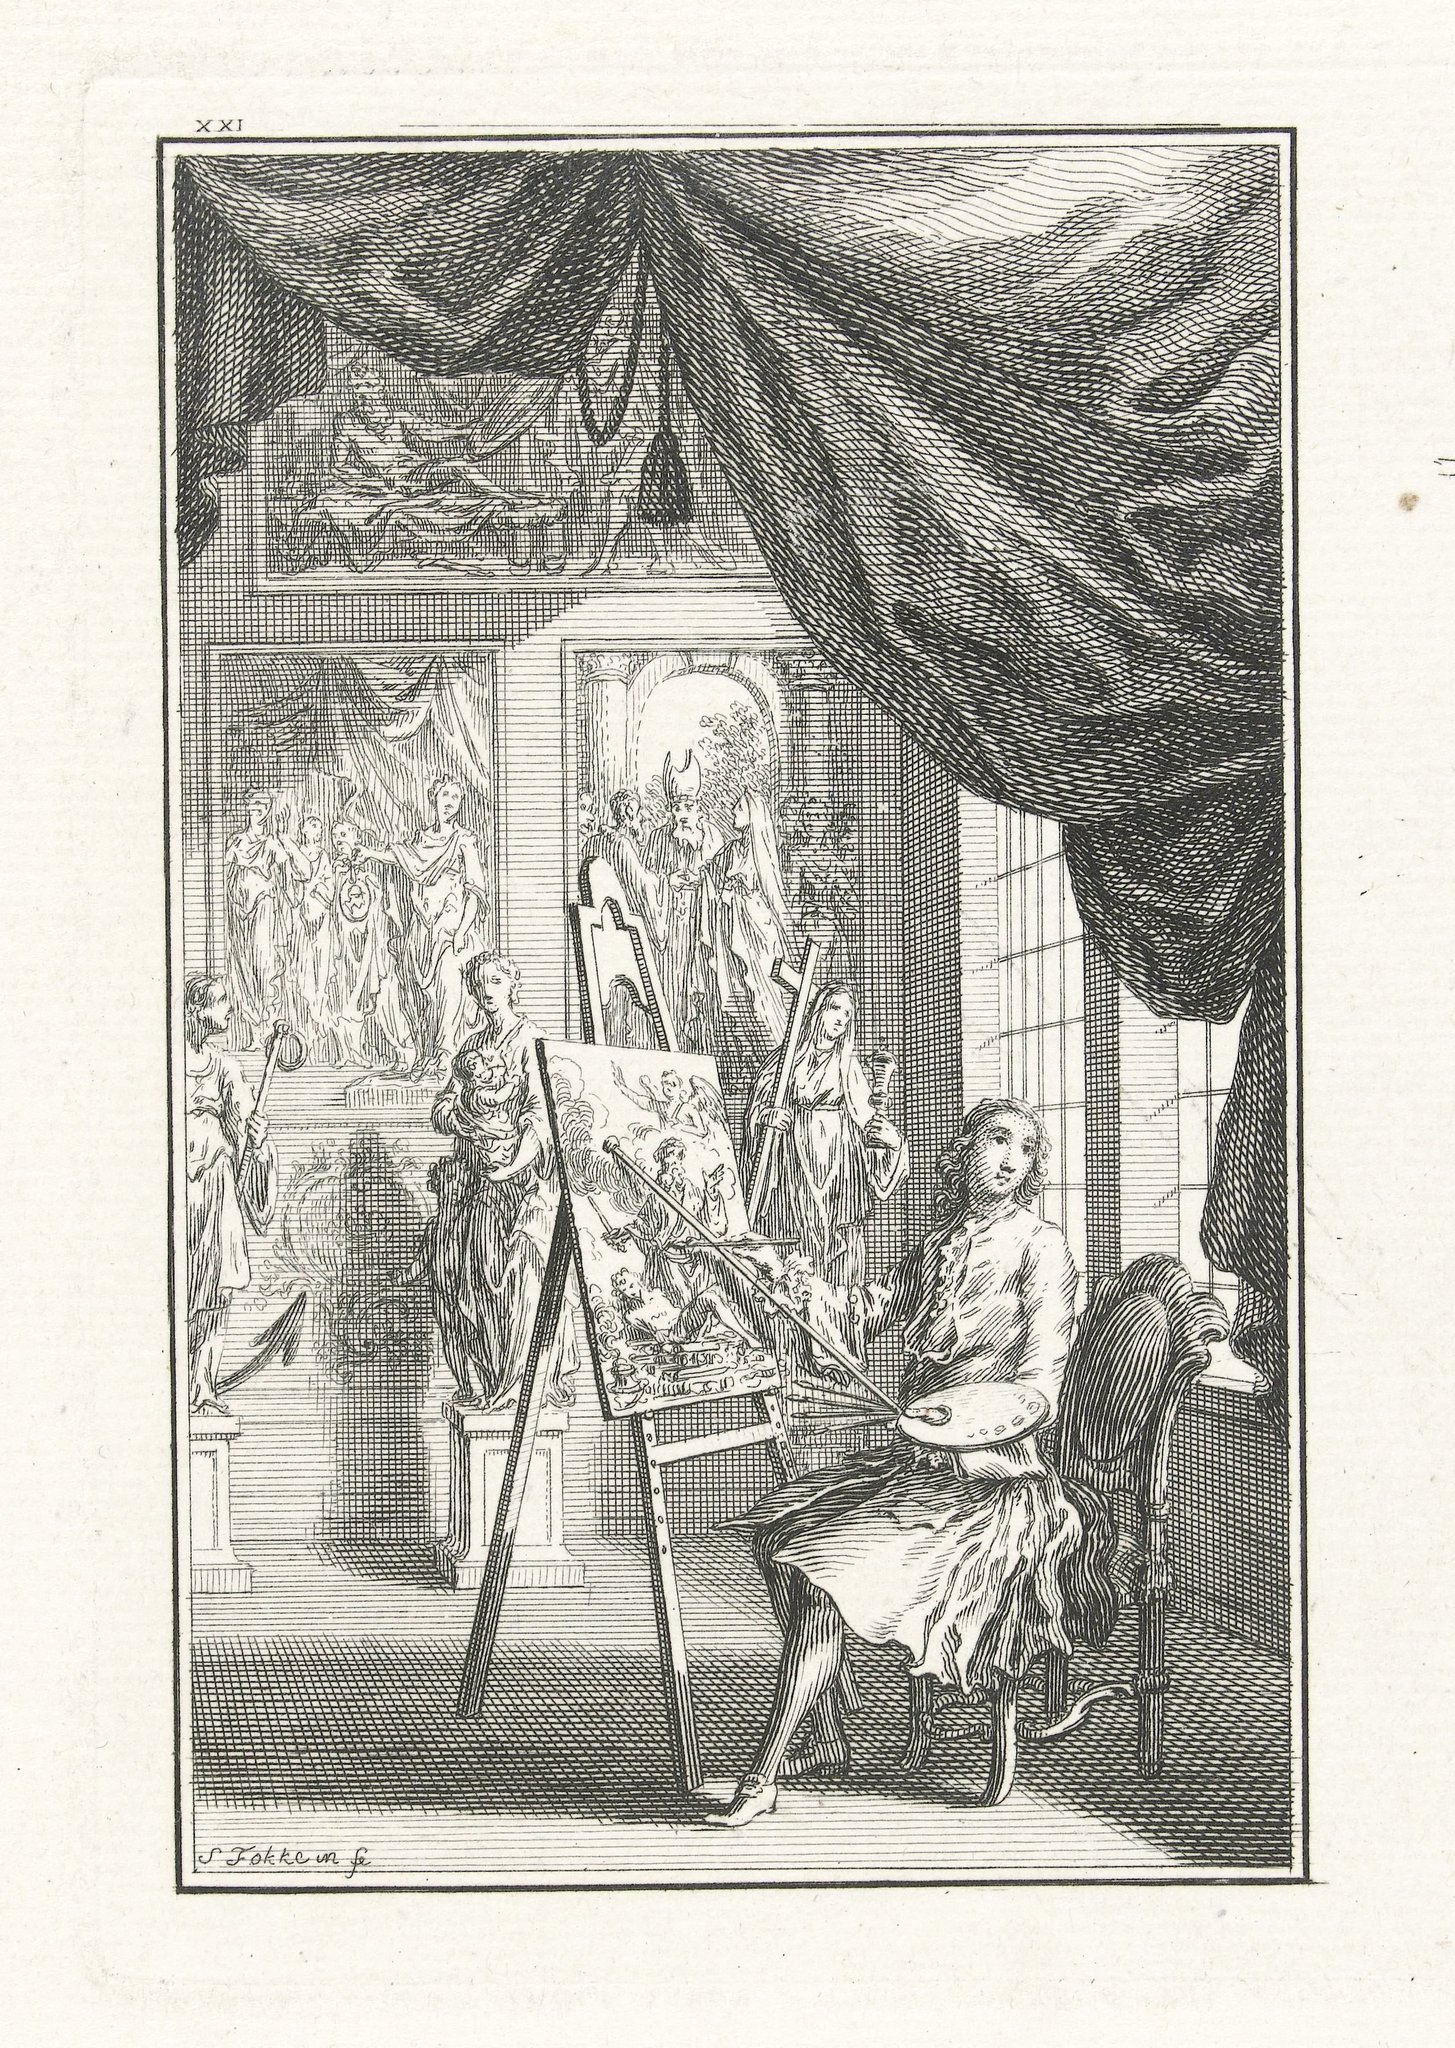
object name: print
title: Schilder aan het werk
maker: simon fokke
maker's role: draughtsman, print maker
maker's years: 1712-1784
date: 1722-1784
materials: paper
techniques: etching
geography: amsterdam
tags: painter at work, in his studio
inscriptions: collector's mark: Lugt 2228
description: Schilder aan het werk in een ruimte waar diverse schilderijen aan de muur hangen en een aantal standbeelden staan. Prent linksboven gemerkt: XXI.